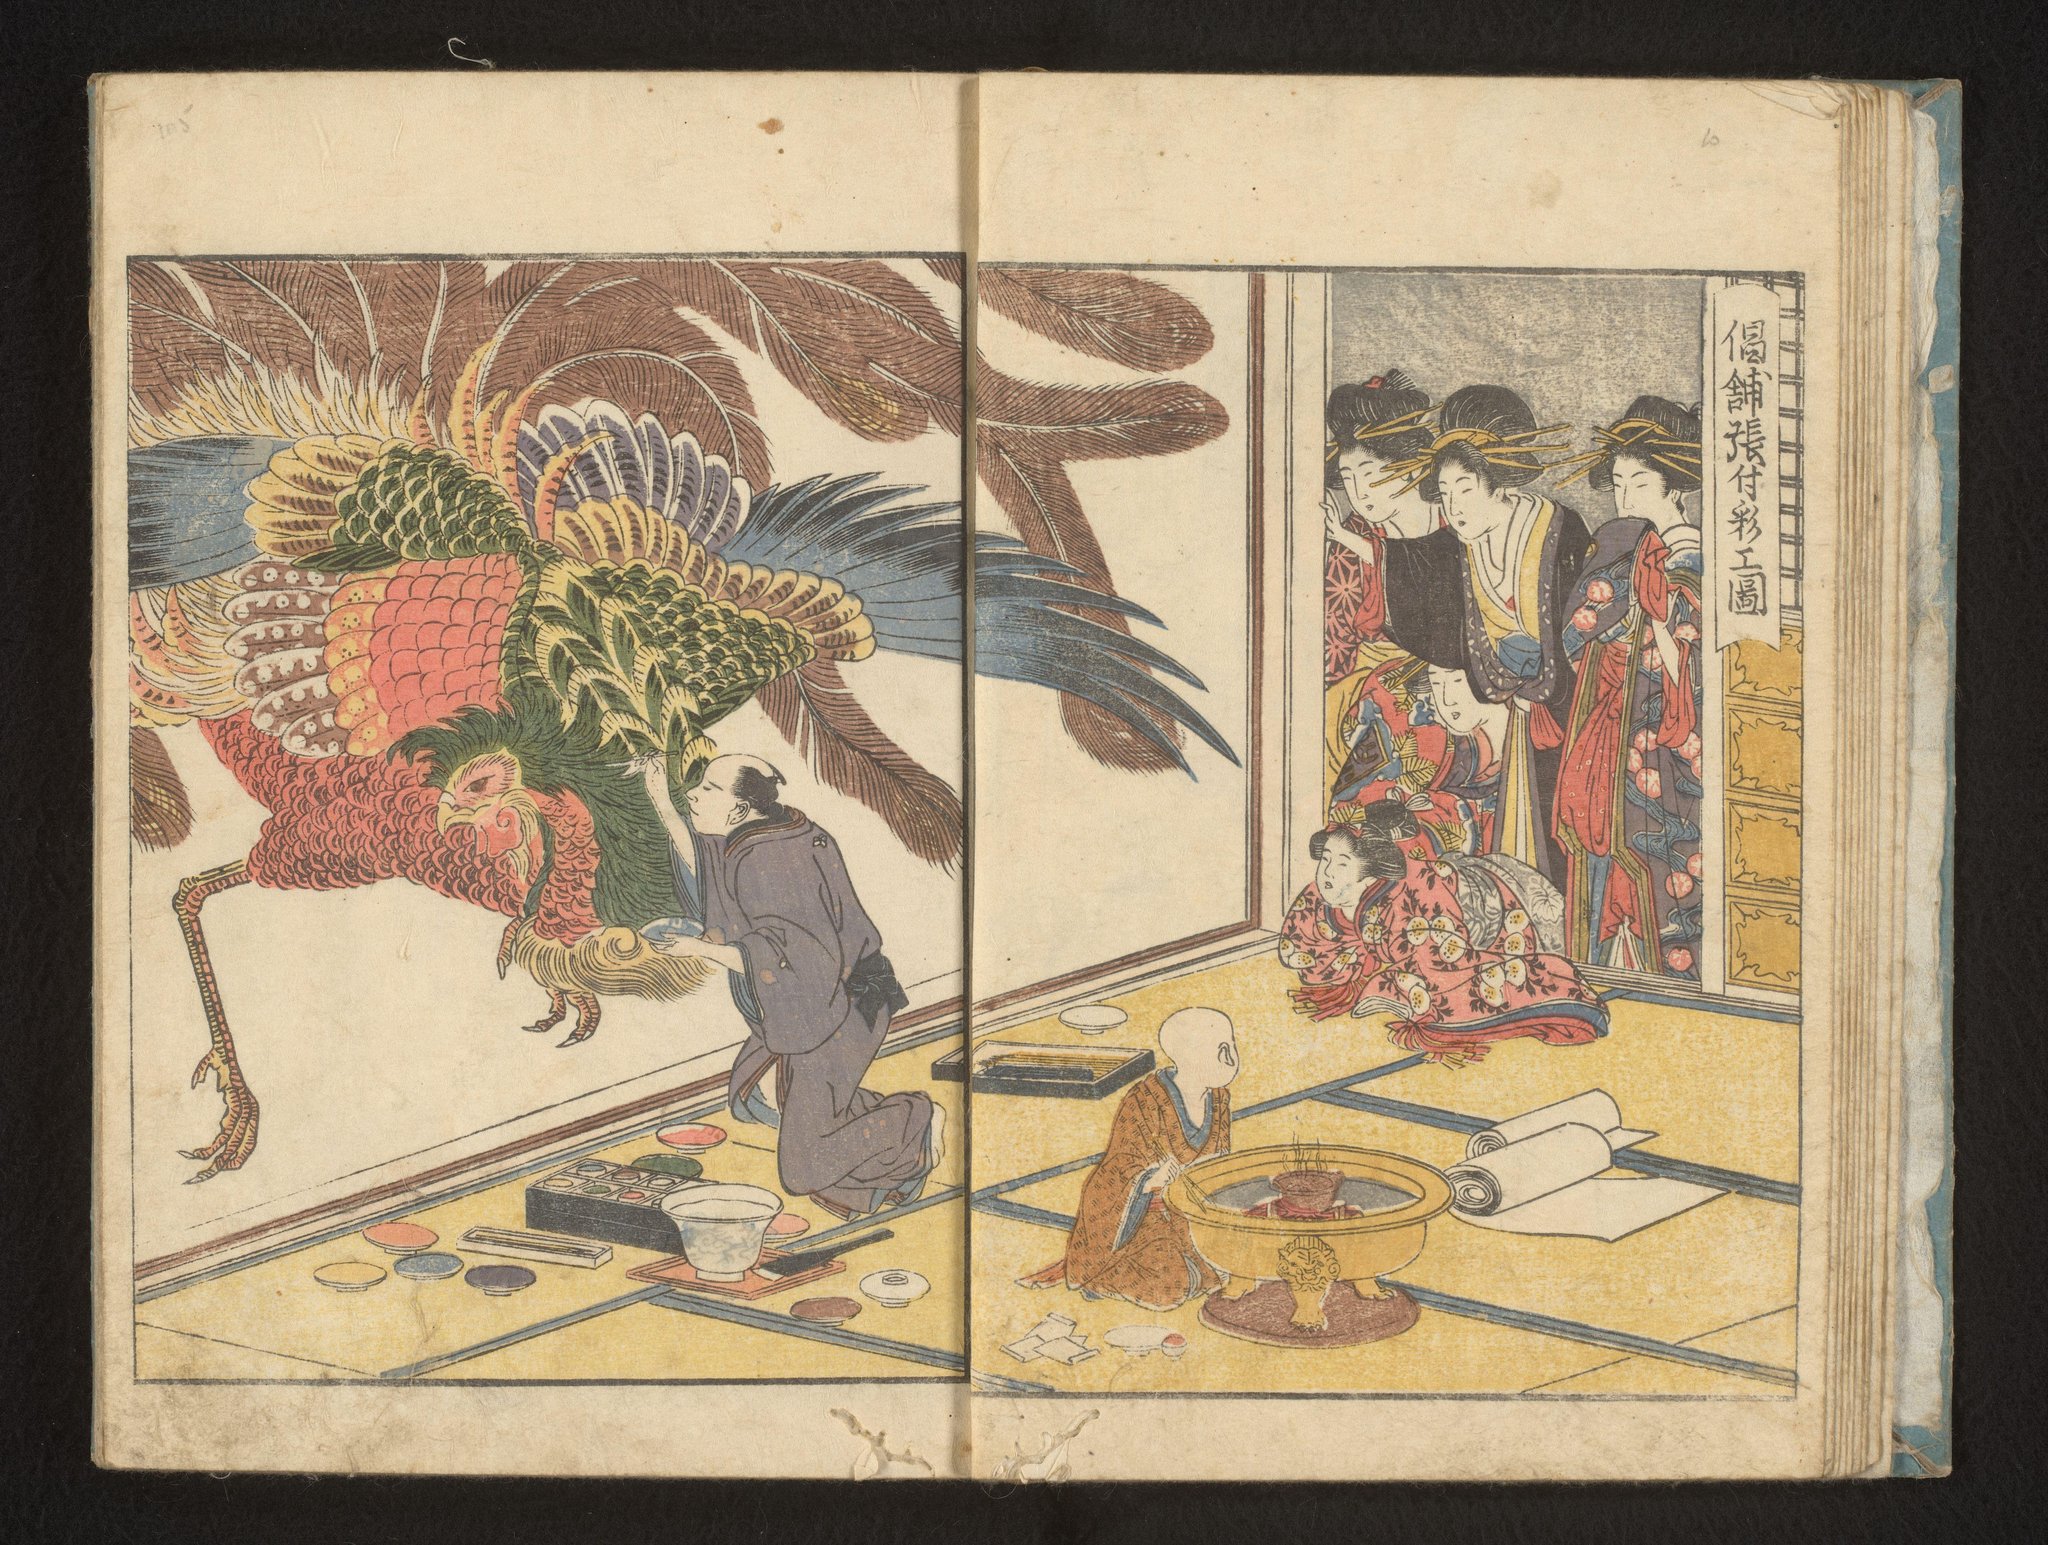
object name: page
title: Muurschildering maken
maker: kitagawa utamaro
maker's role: print maker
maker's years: 1753-1806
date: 1804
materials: paper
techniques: woodcut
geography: edo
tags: mural painter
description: Achttiende en negentiende pagina van deel twee van Utamaro`s boek: Gebeurtenissen in de lusthuizen gedurende het jaar.